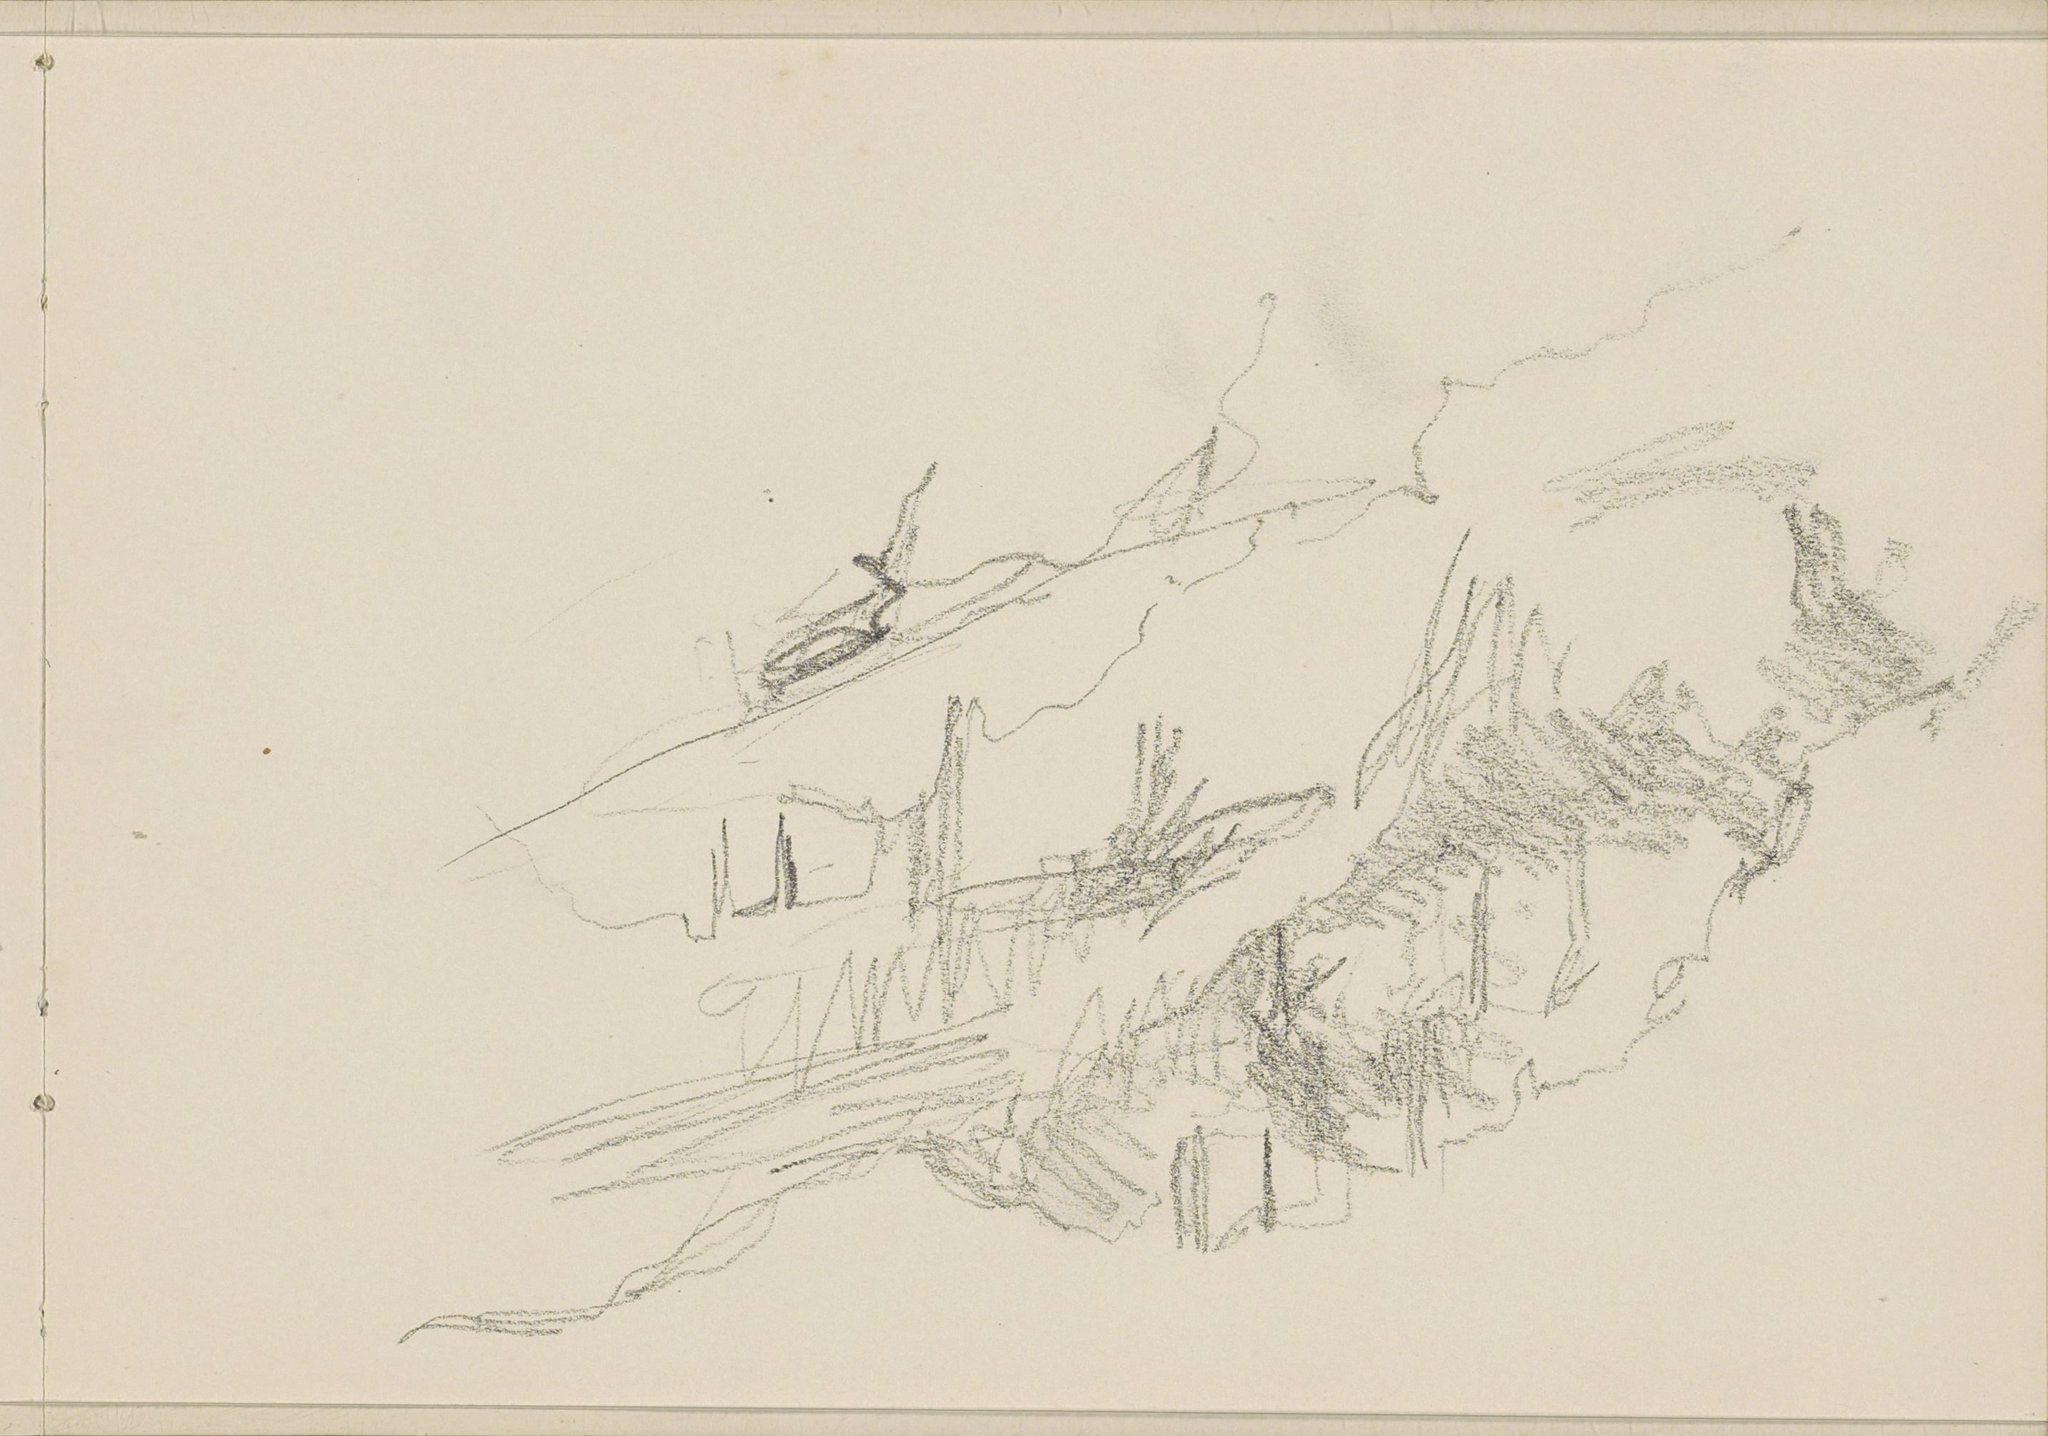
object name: sketchbook leaf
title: Bomen tegen een berg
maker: a.a.l. de grammont-hubrecht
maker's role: draughtsman, painter, print maker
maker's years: 1855-1913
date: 1865-1913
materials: paper, pencil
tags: trees, mountains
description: Blad 6 recto uit een schetsboek met 68 bladen.